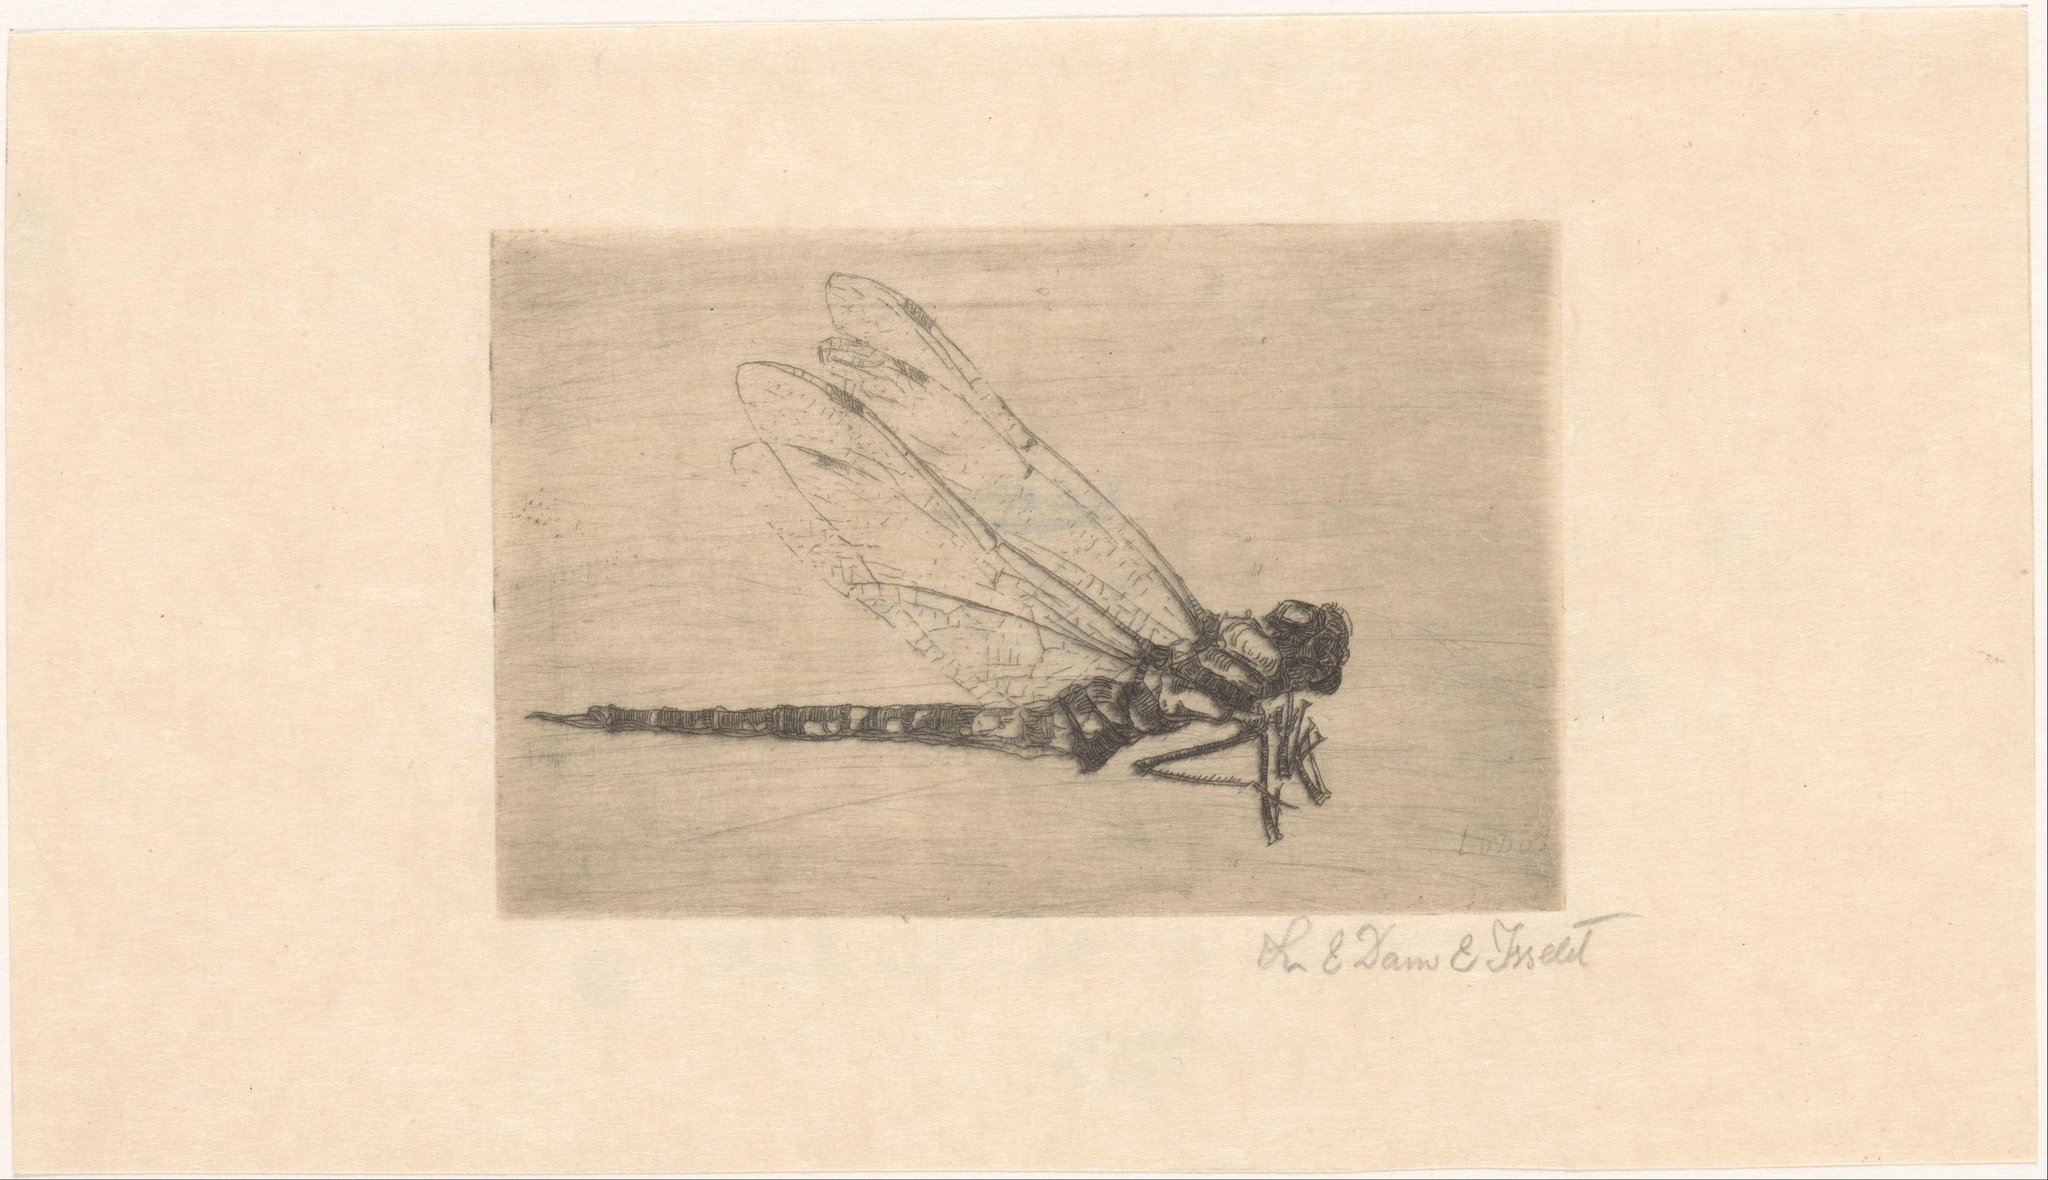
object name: print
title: Libel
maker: lucie van dam van isselt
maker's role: draughtsman, print maker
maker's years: 1871-1949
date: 1881-1936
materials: paper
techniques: etching, intaglio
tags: insects: dragon-fly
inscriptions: collector's mark: Lugt 2760, collector's mark: Lugt 2228